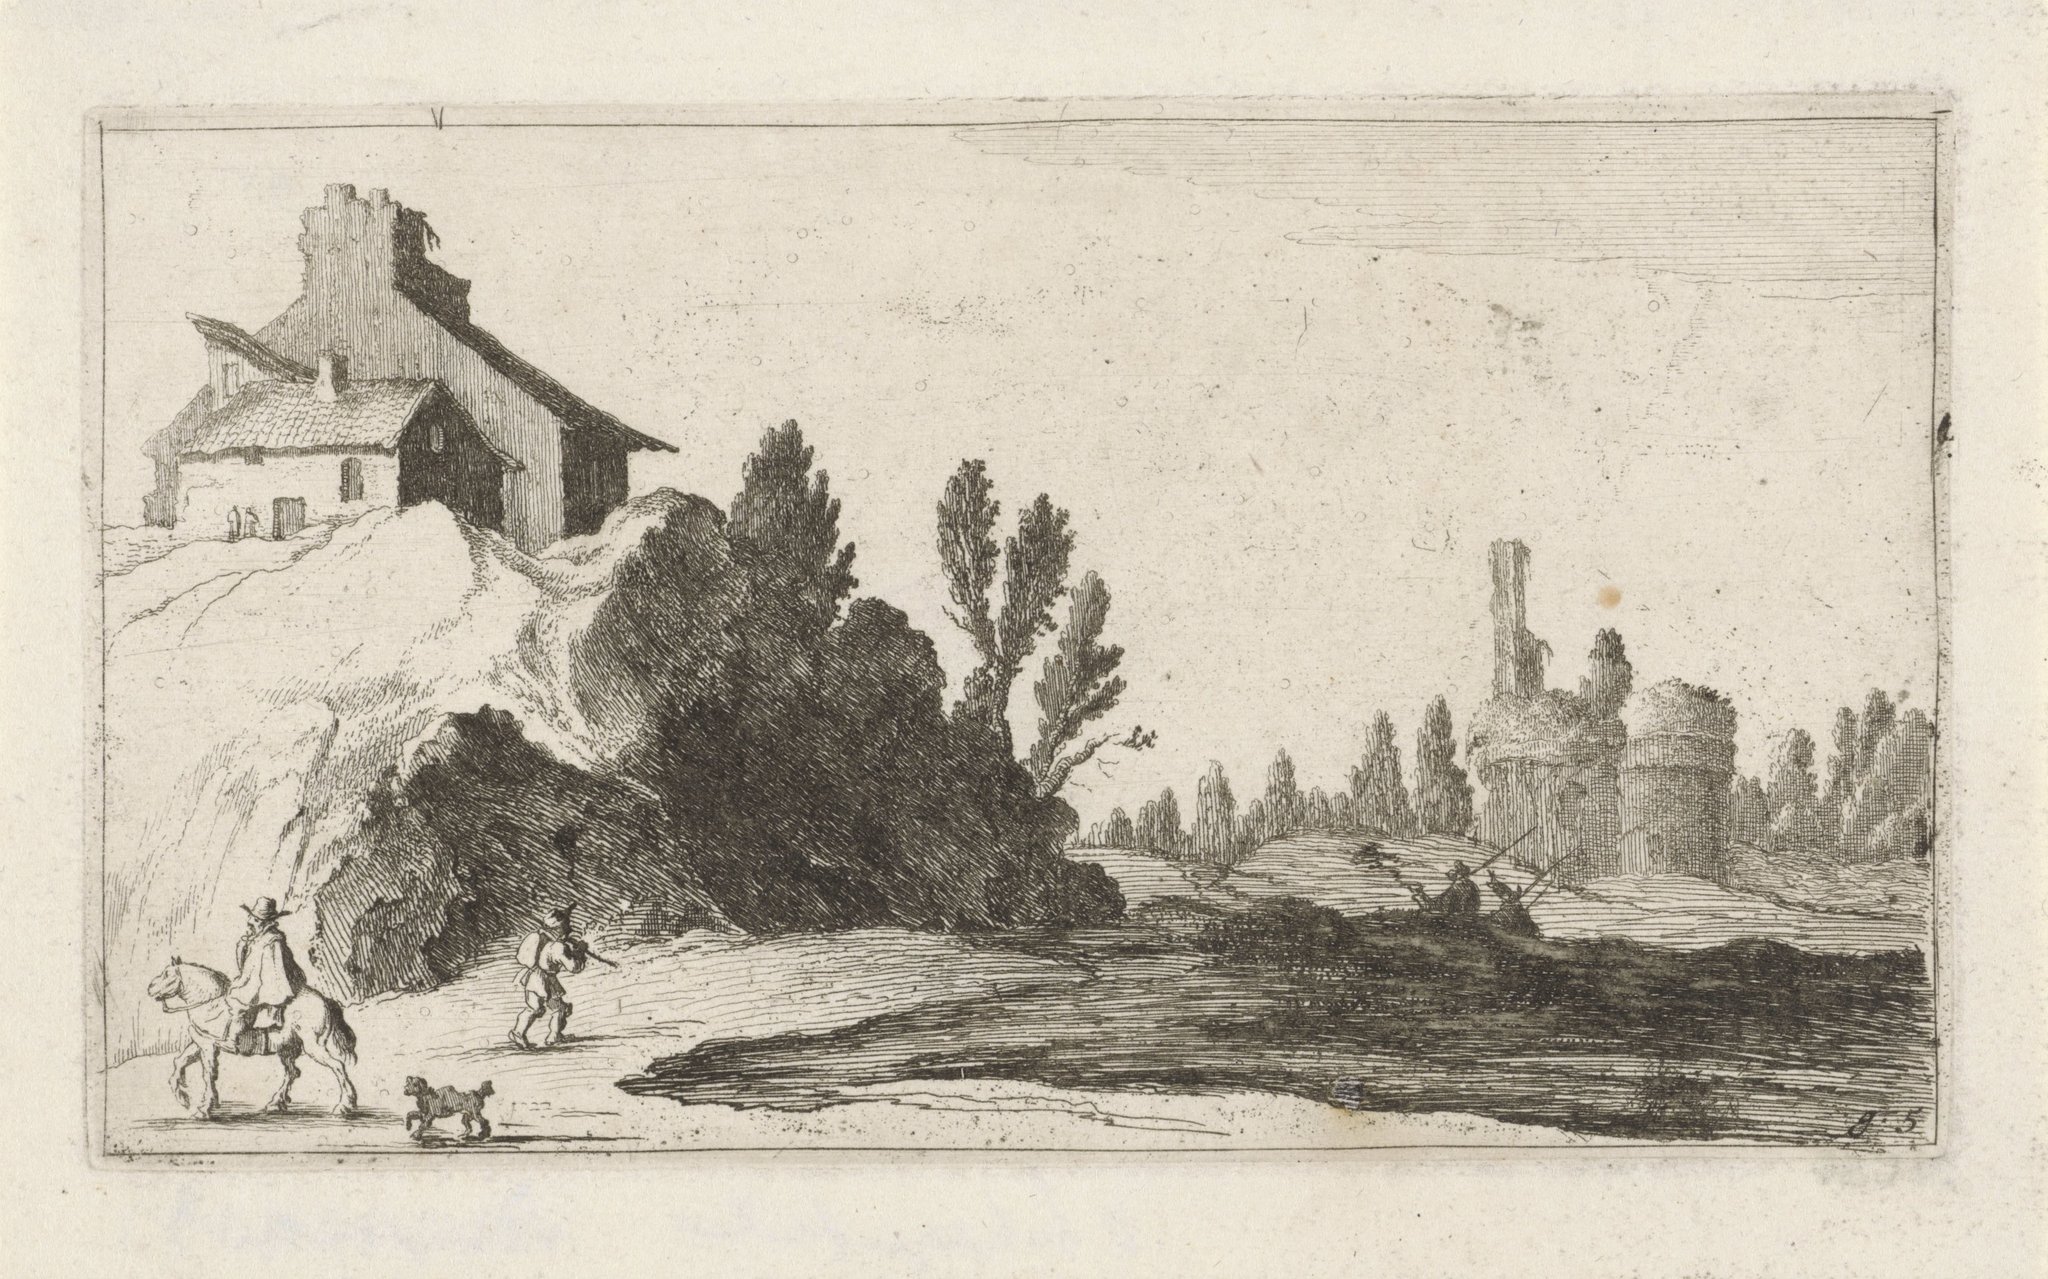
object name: print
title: Boerderij op een heuvel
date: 1605-1653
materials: paper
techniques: engraving, etching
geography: amsterdam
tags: riding a horse, ass, or mule; rider, horseman, landscape with ruins, farm or solitary house in landscape, fisherman, dog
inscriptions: collector's mark: Lugt 2165, collector's mark: Lugt 2228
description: Op een heuvel ligt een boerderij waar een landweg langs loopt. Op de weg een ruiter, een wandelaar en een hond. Op de achtergrond twee vissers en een ruïne. De prent maakt deel uit van een serie van twaalf landschappen.